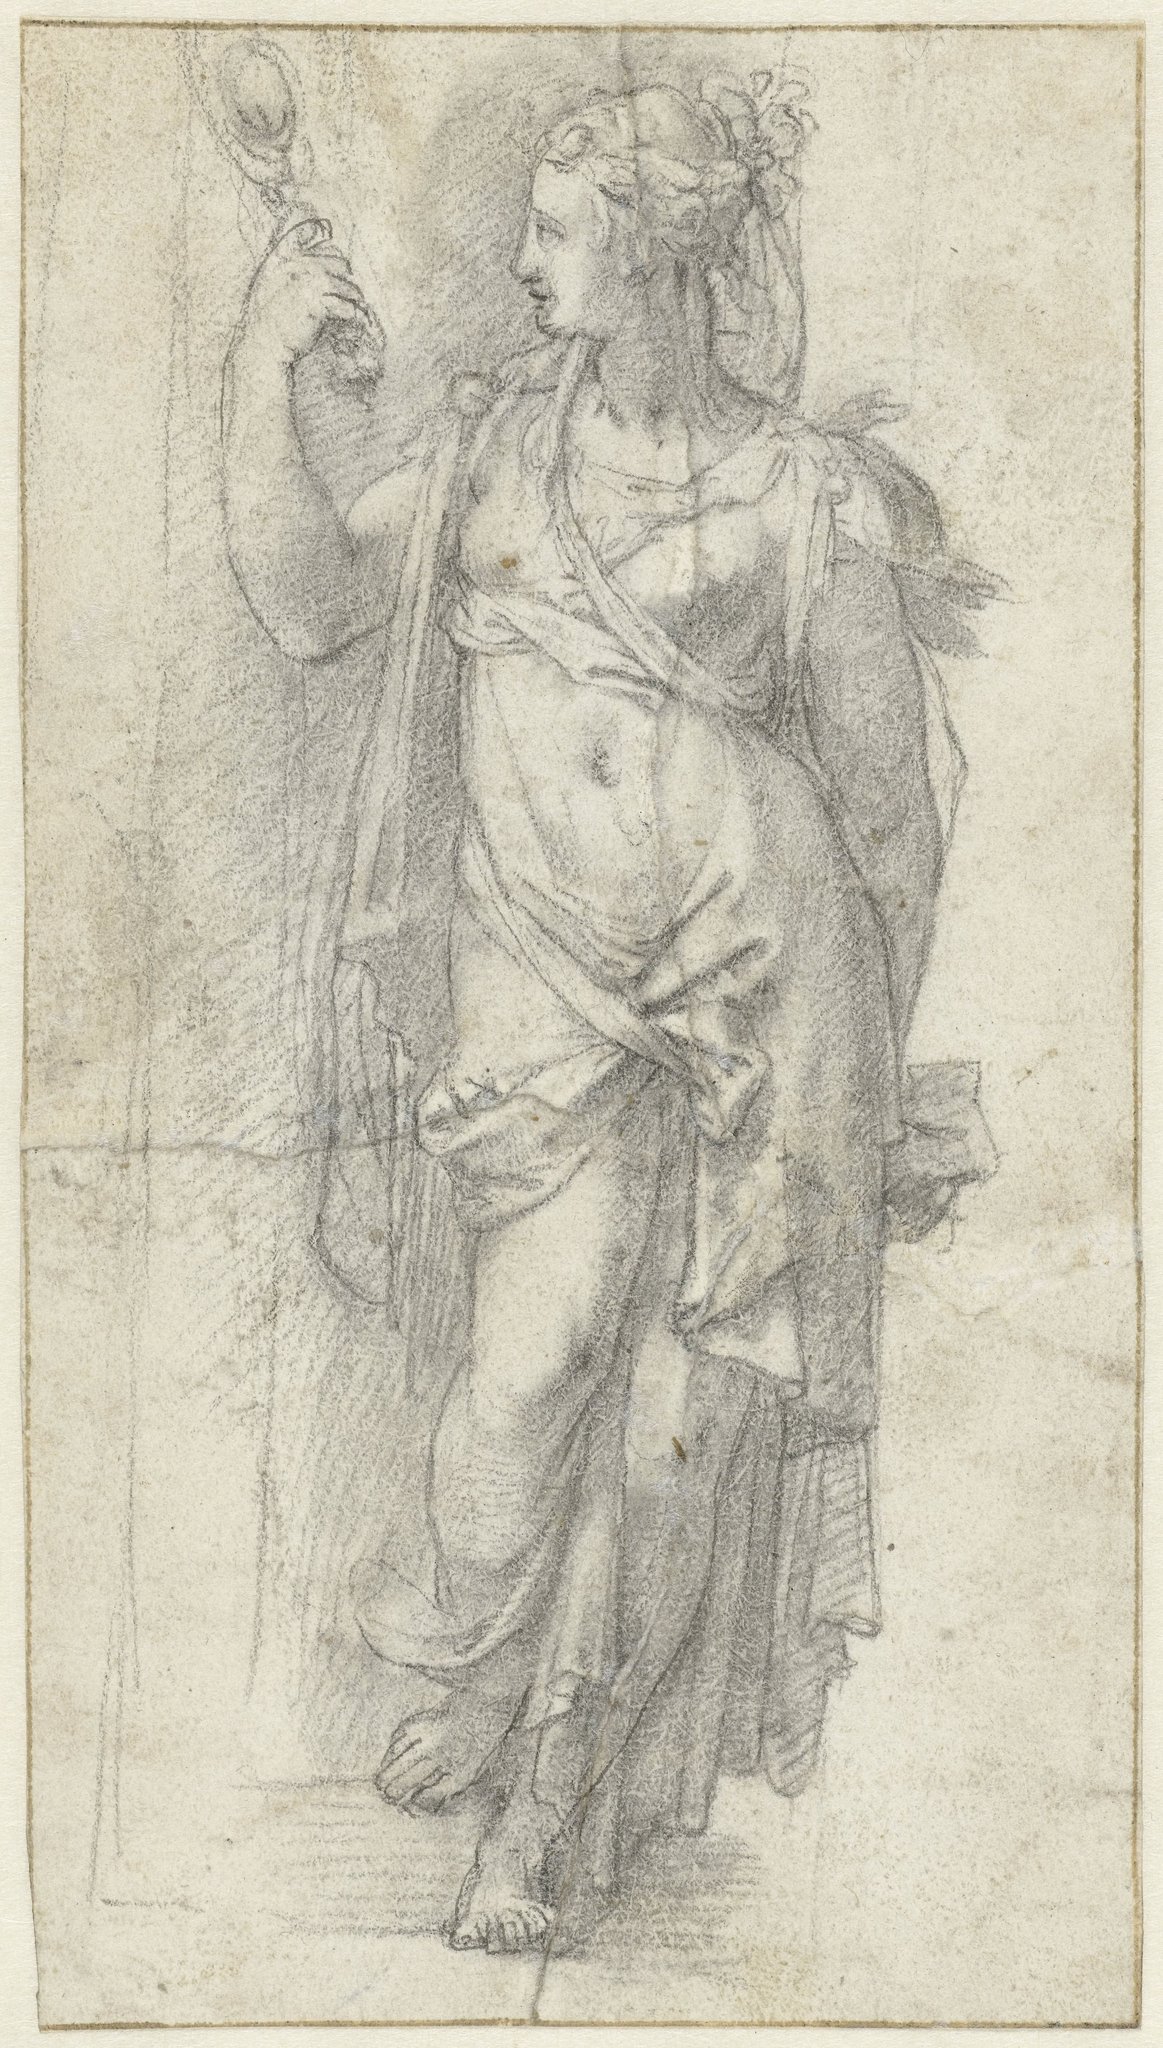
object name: drawing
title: Prudentia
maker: alessandro allori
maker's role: draughtsman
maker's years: 1535-1607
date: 1570-1582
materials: chalk, paper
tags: prudence, 'prudentia'; 'prudenza' (ripa) ~ one of the four cardinal virtues